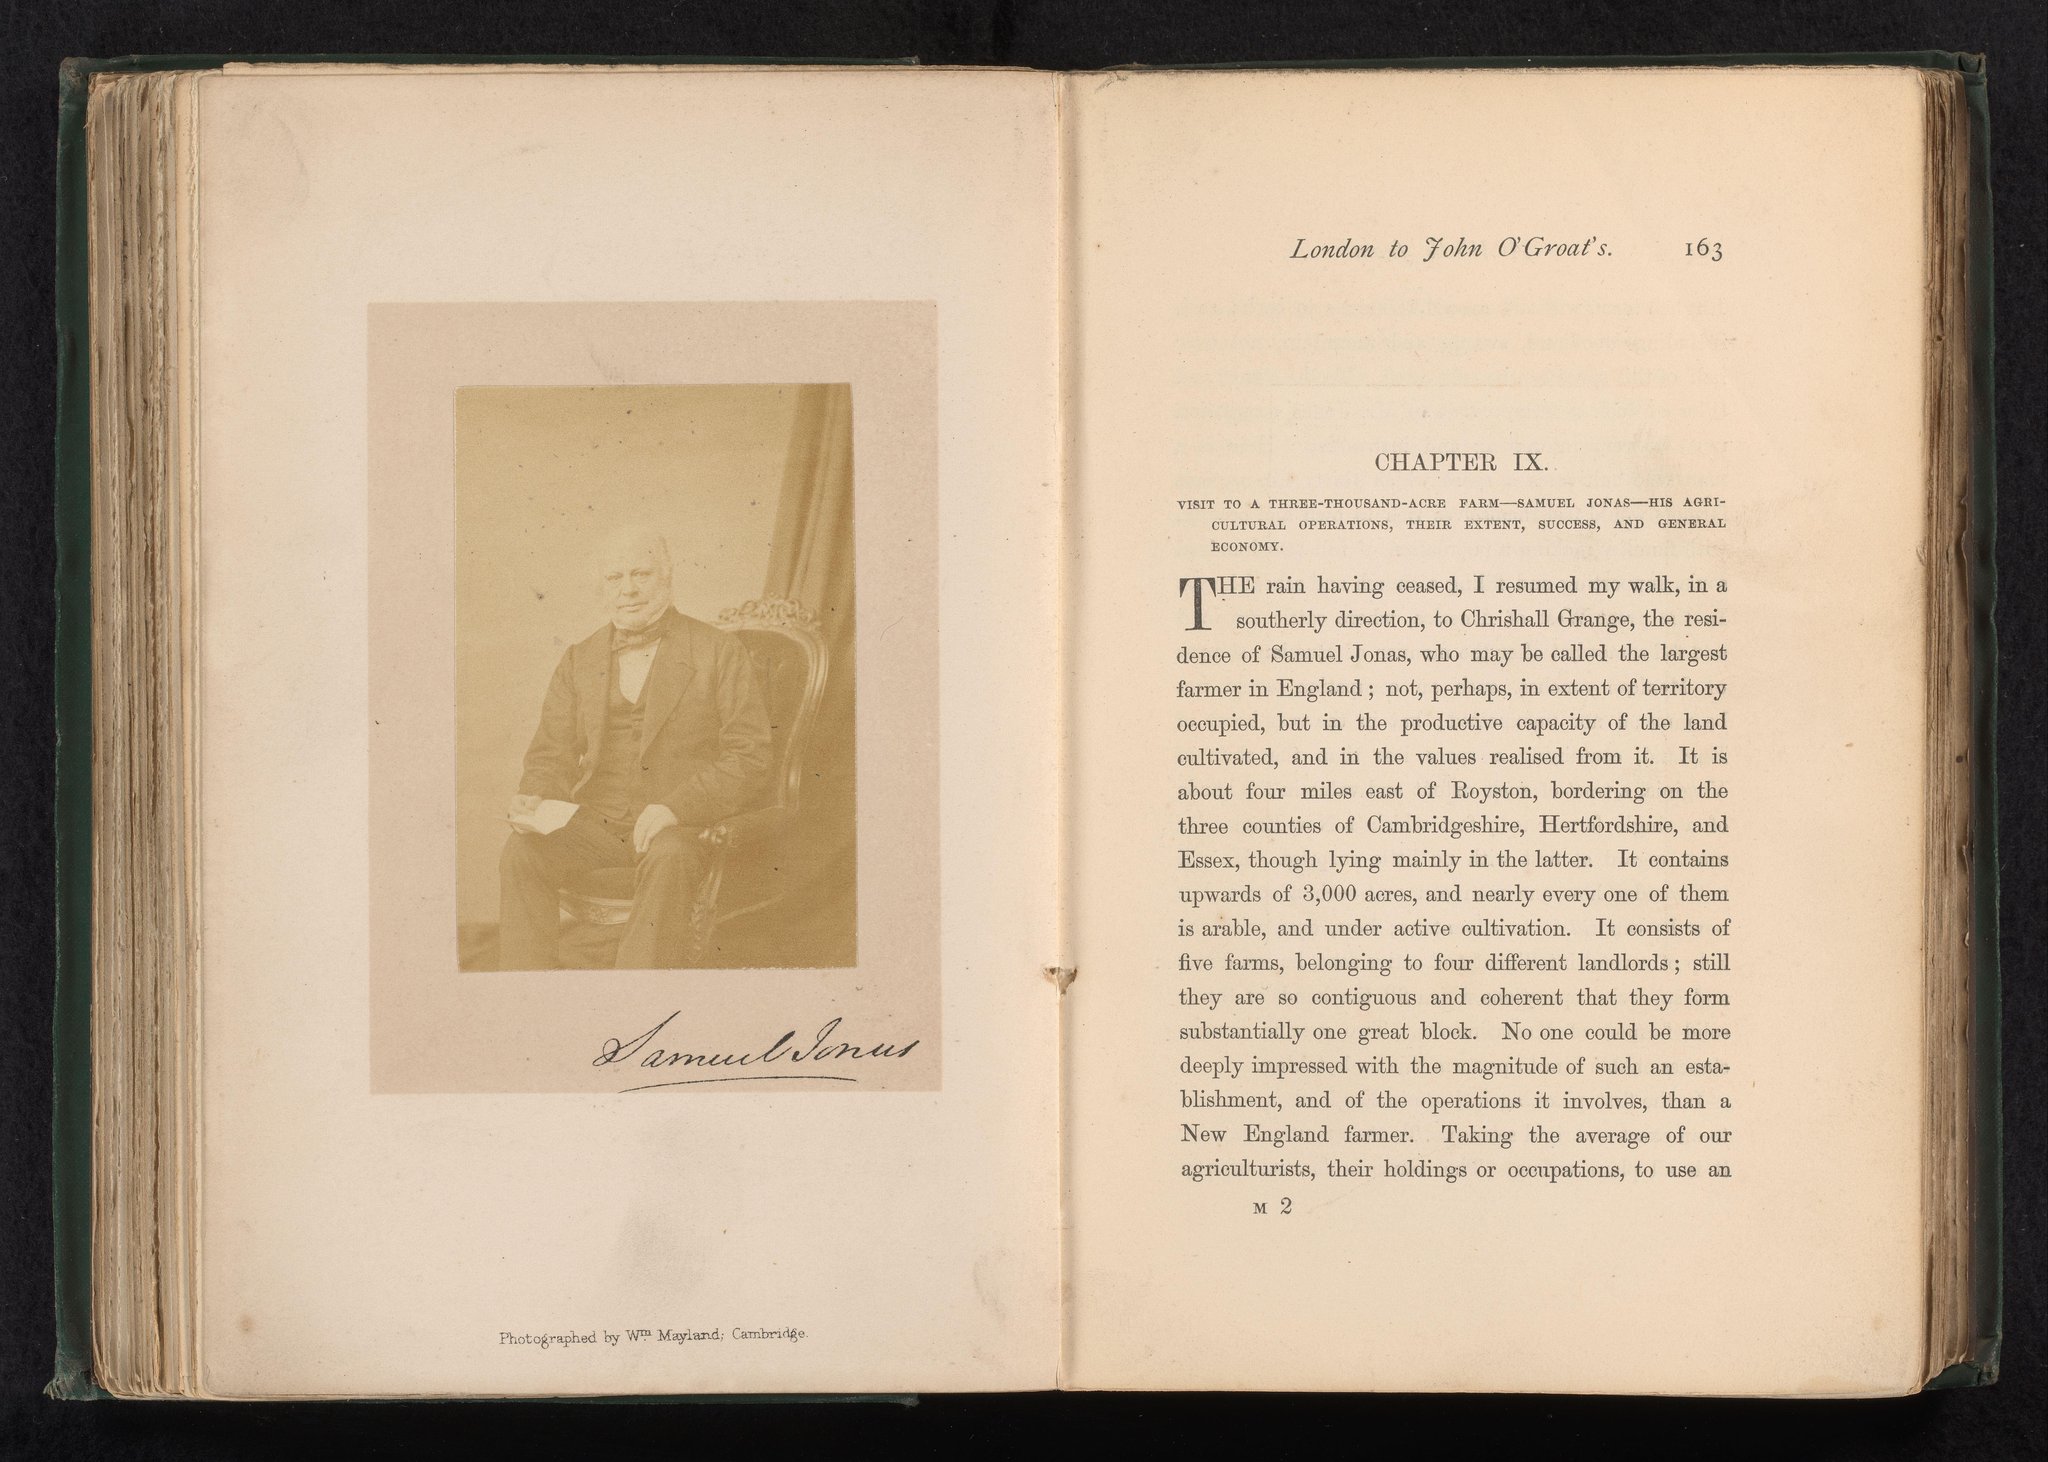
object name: photograph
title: Portret van Samuel Jonas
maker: william mayland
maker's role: fotograaf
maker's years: 1821-1907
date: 1859-1864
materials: paper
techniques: albumen print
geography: cambridge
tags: historical persons, farmers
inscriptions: inscription: ‘Samuel Jonas’, address: ‘Photographed by Wm Mayland, Cambridge’